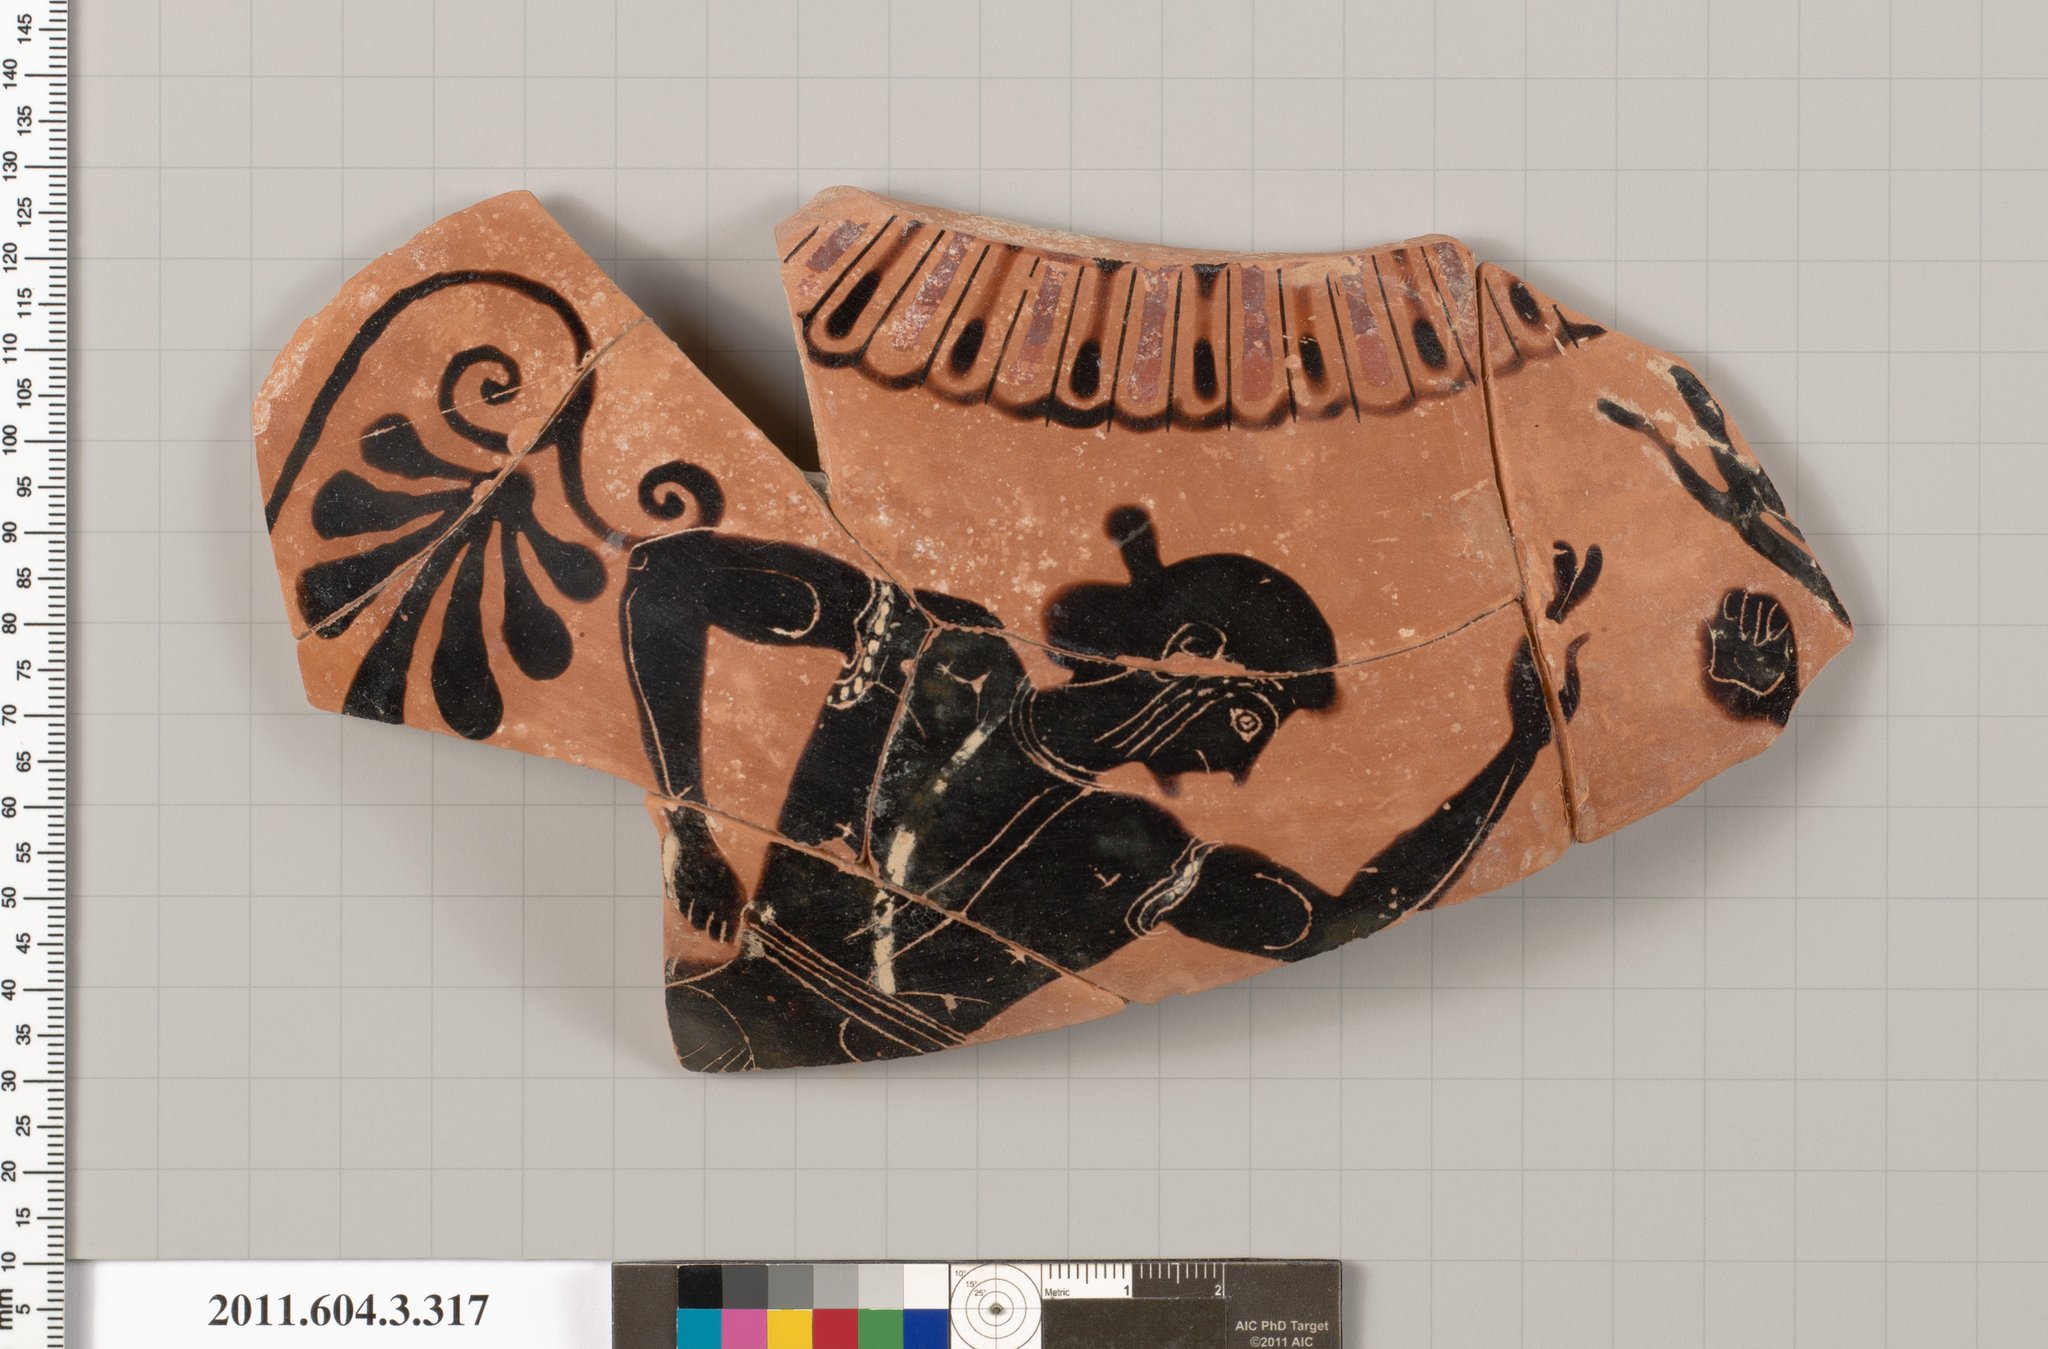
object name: neck amphora fragment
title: Terracotta fragment of a neck-amphora (jar)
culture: greek, attic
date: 525-501 BCE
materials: terracotta